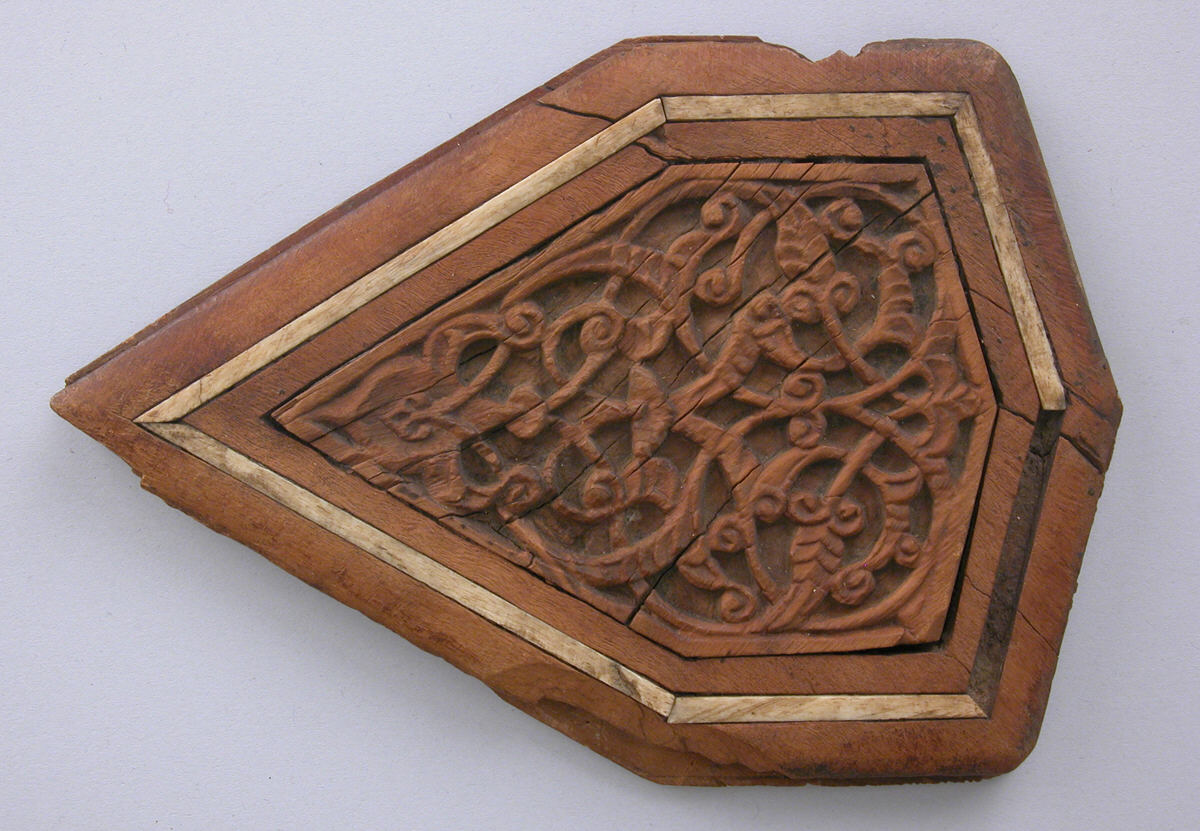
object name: panel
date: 1201-1400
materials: bone, ivory, wood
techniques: carving, inlay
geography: egypt